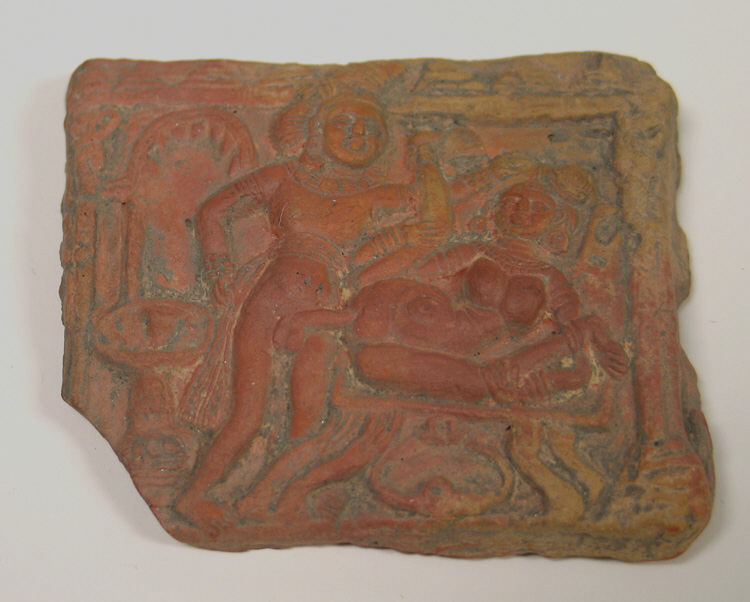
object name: plaque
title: Plaque with Erotic Scene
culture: indian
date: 100-1 BCE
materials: terracotta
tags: shunga,male nudes,female nudes